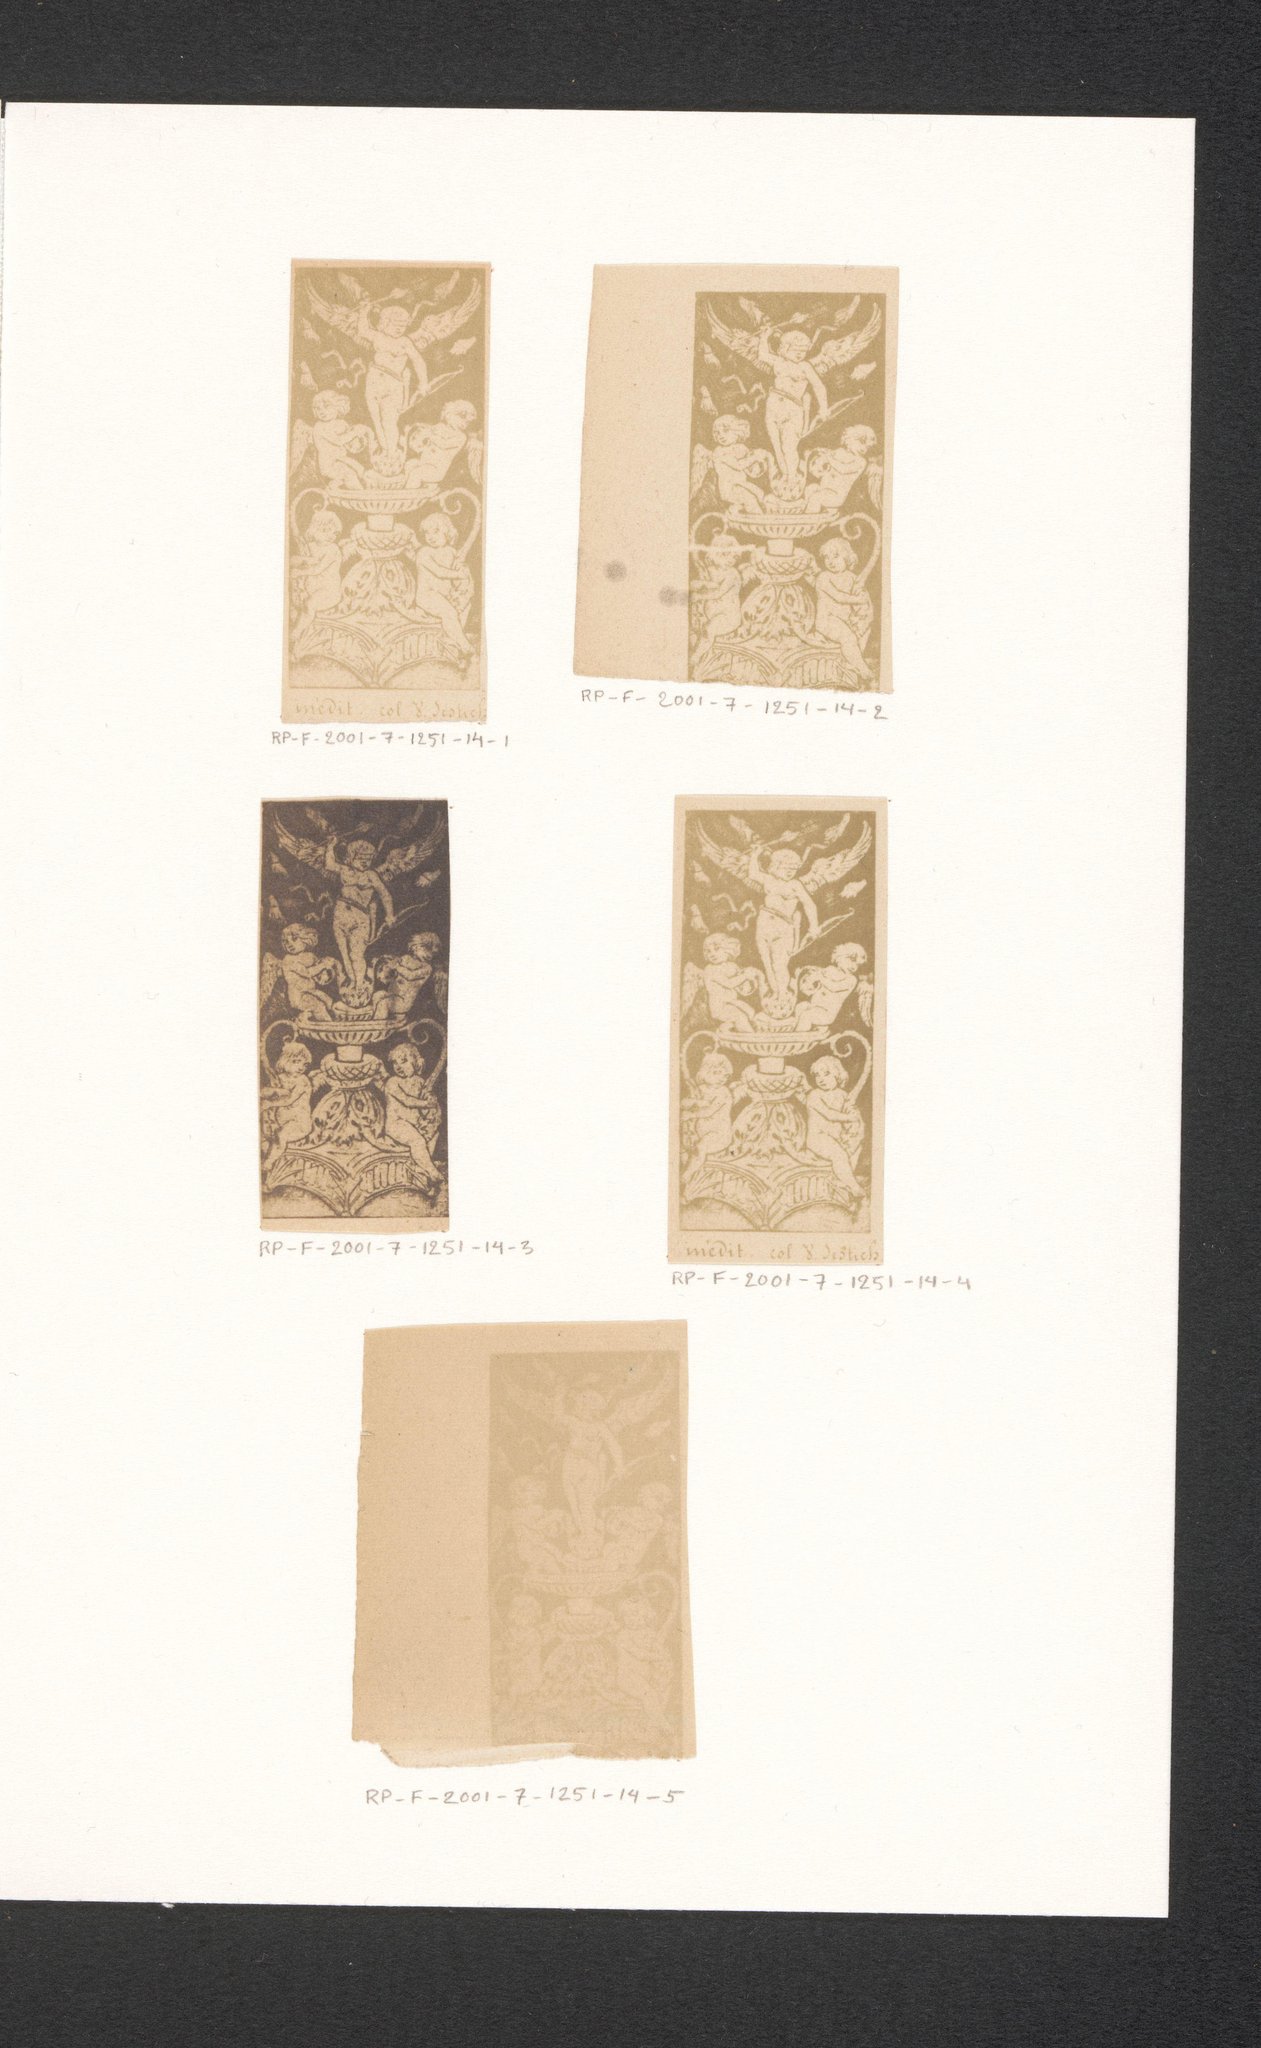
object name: photograph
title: Fotoreproductie van een prent van de triomf van de liefde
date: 1852-1857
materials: photographic support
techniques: salted paper print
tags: vase ~ ornament, cupids: 'amores', 'amoretti', 'putti'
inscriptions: inscription: ‘medit col. V. Sestic[h]’